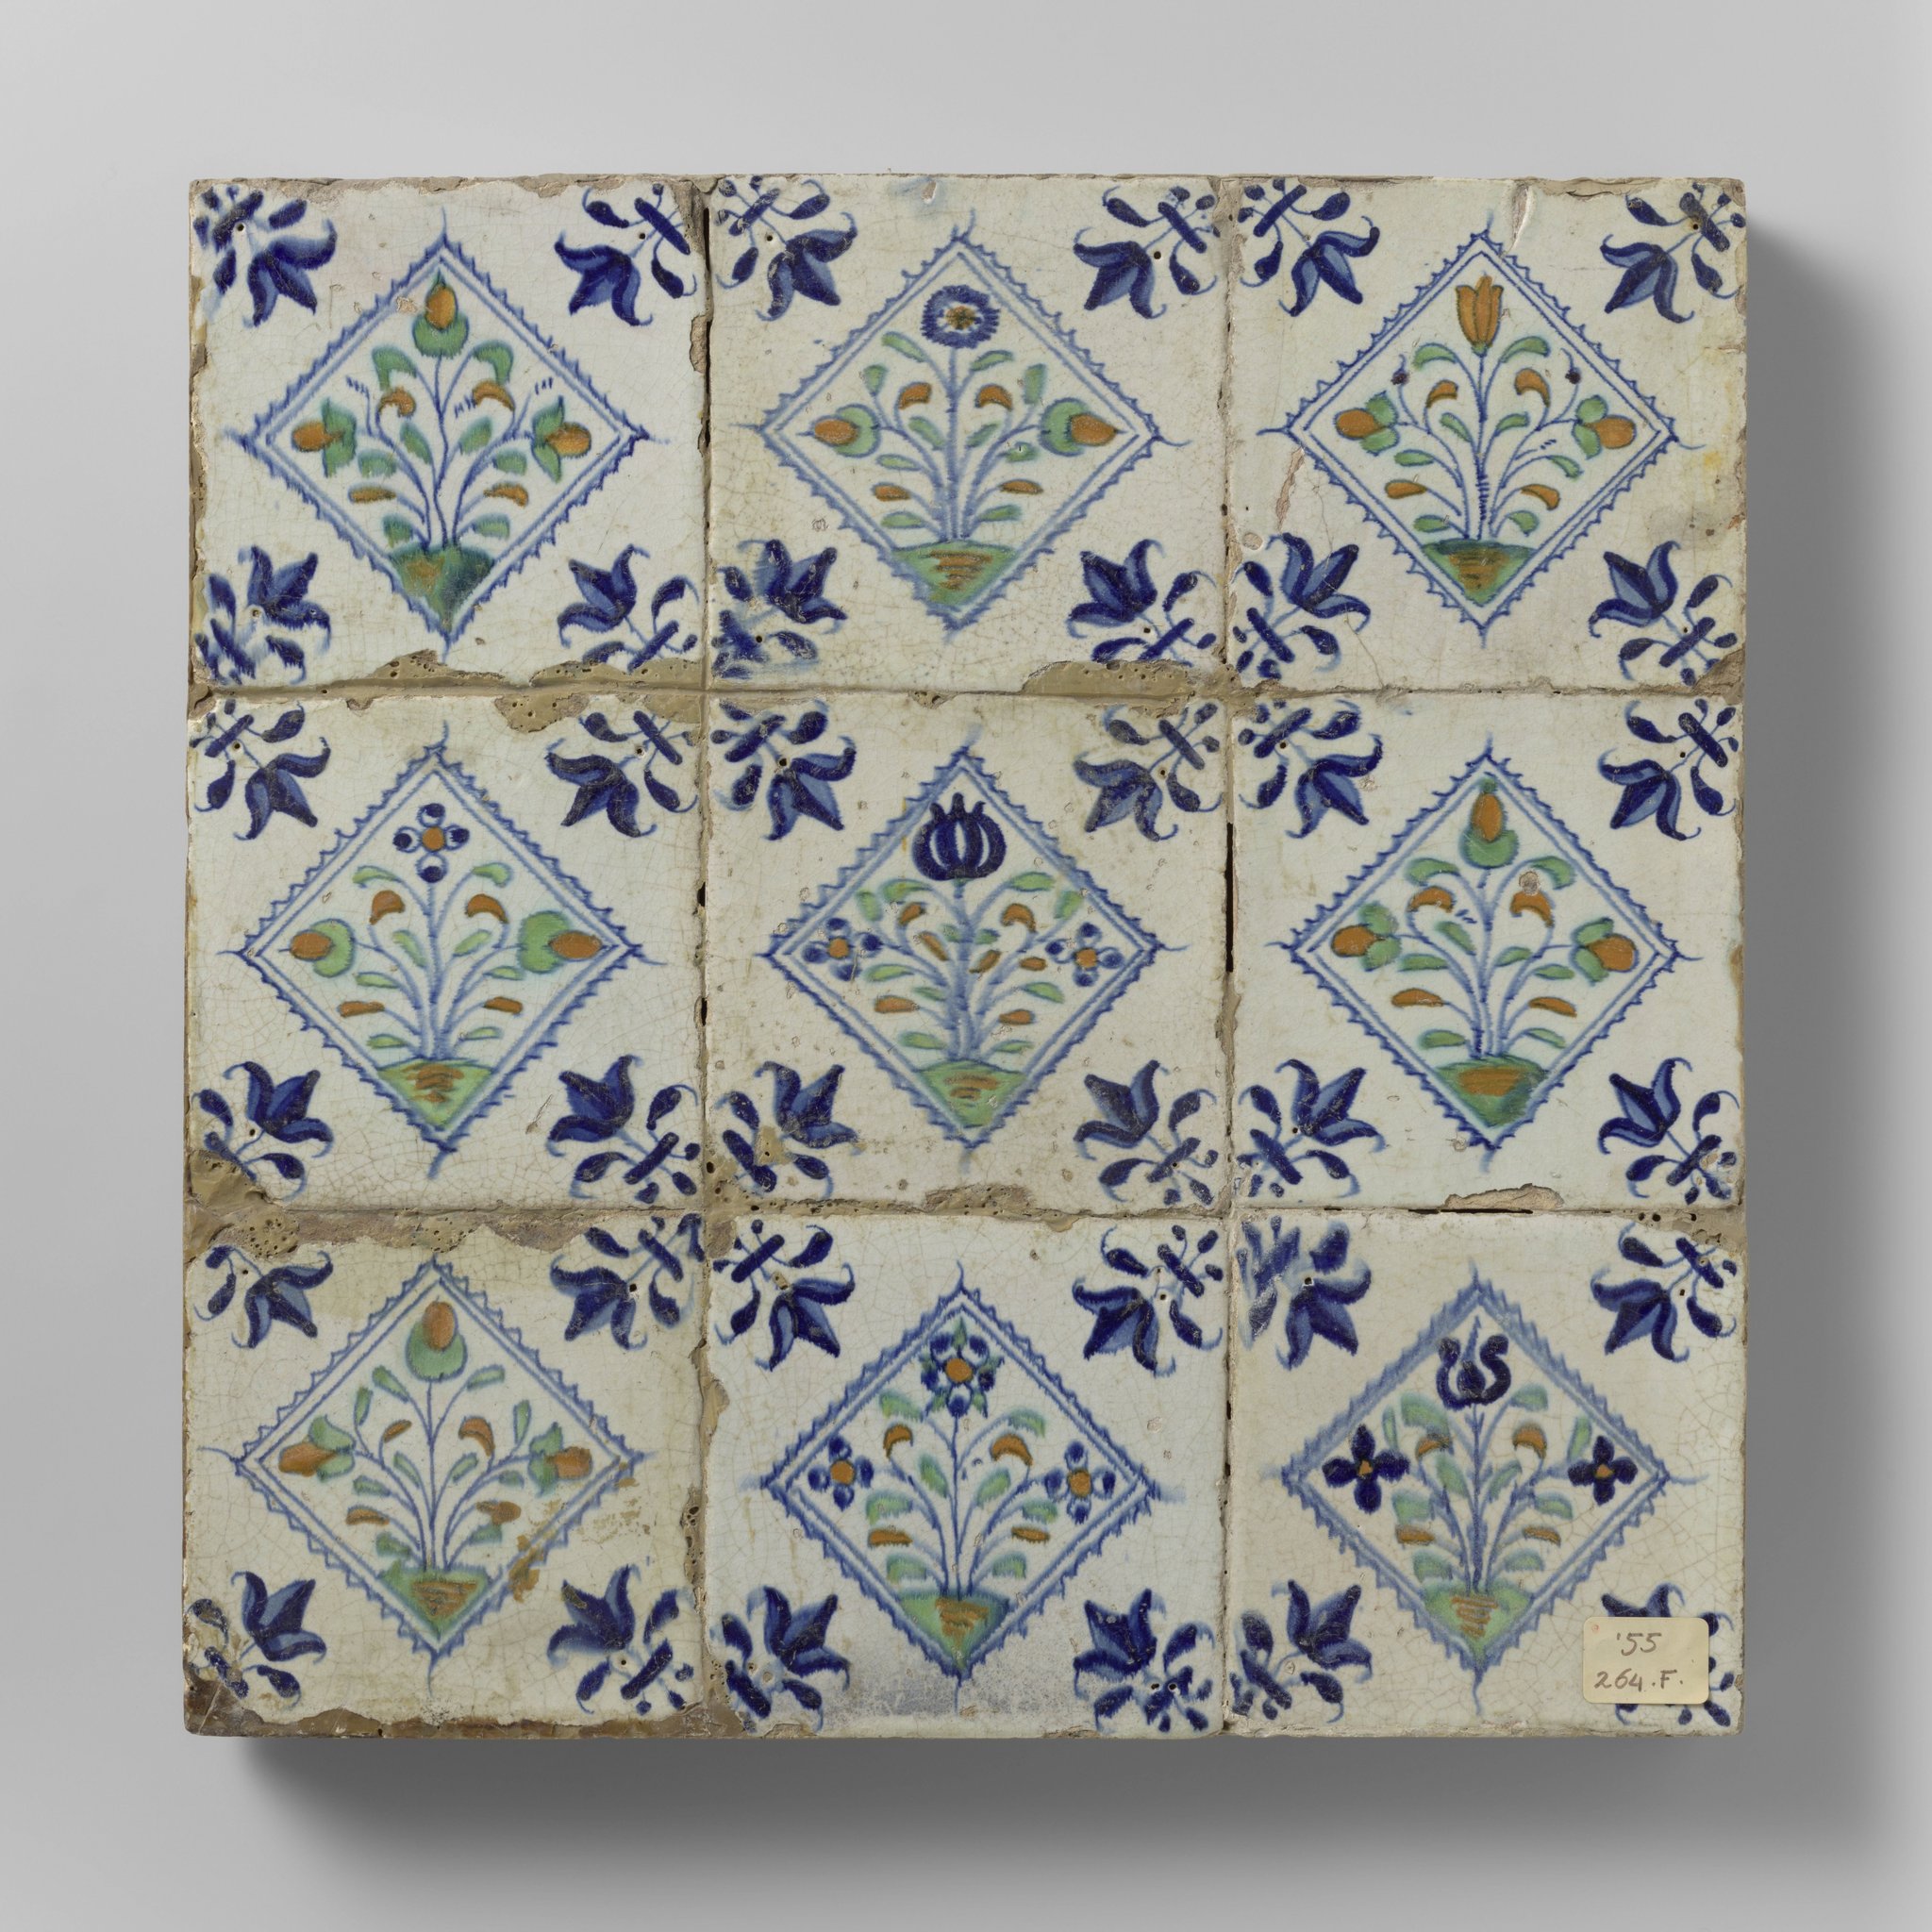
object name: tile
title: Veld van negen tegels met bloemen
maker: Anonymous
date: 1640-1670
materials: earthenware, glaze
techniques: maiolica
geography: netherlands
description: Veld van negen tegels (3 x 3) elk met een veelkleurige (blauw, groen, geel en oranje) geschilderde drieledige bloem binnen een kwadraat kussentje. In de hoeken, een lelie.